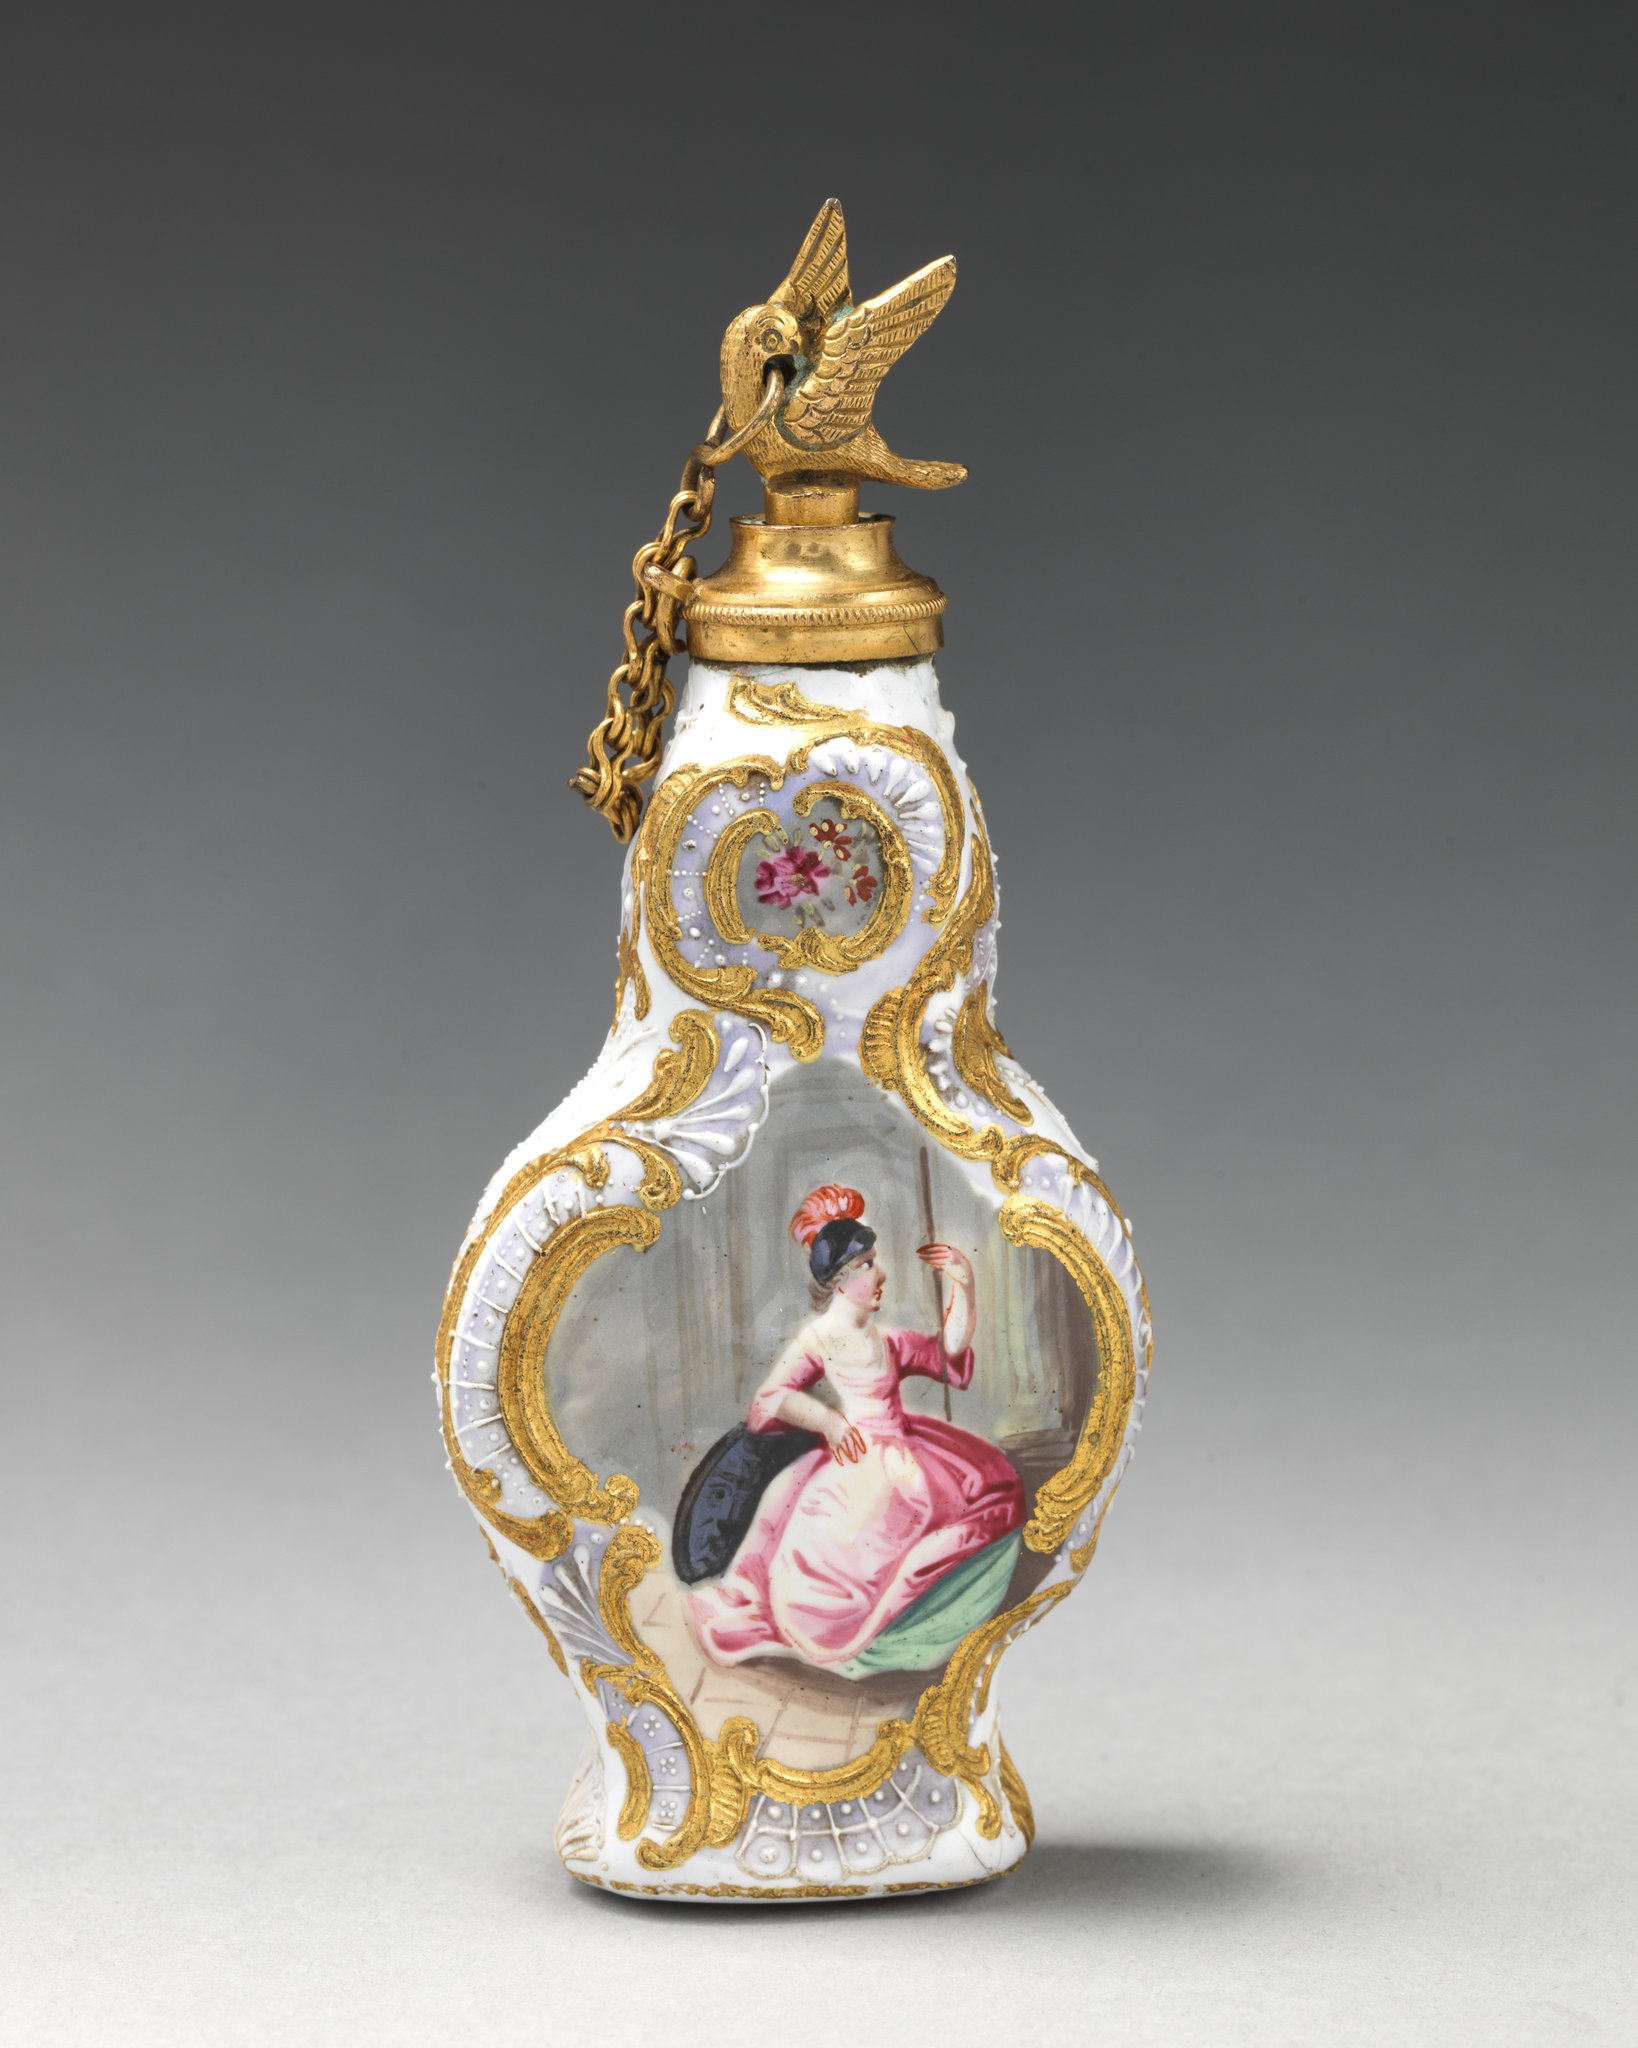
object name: scent bottle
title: Scent bottle with Minerva and Mercury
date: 1760-1800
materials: copper, enamel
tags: birds,women